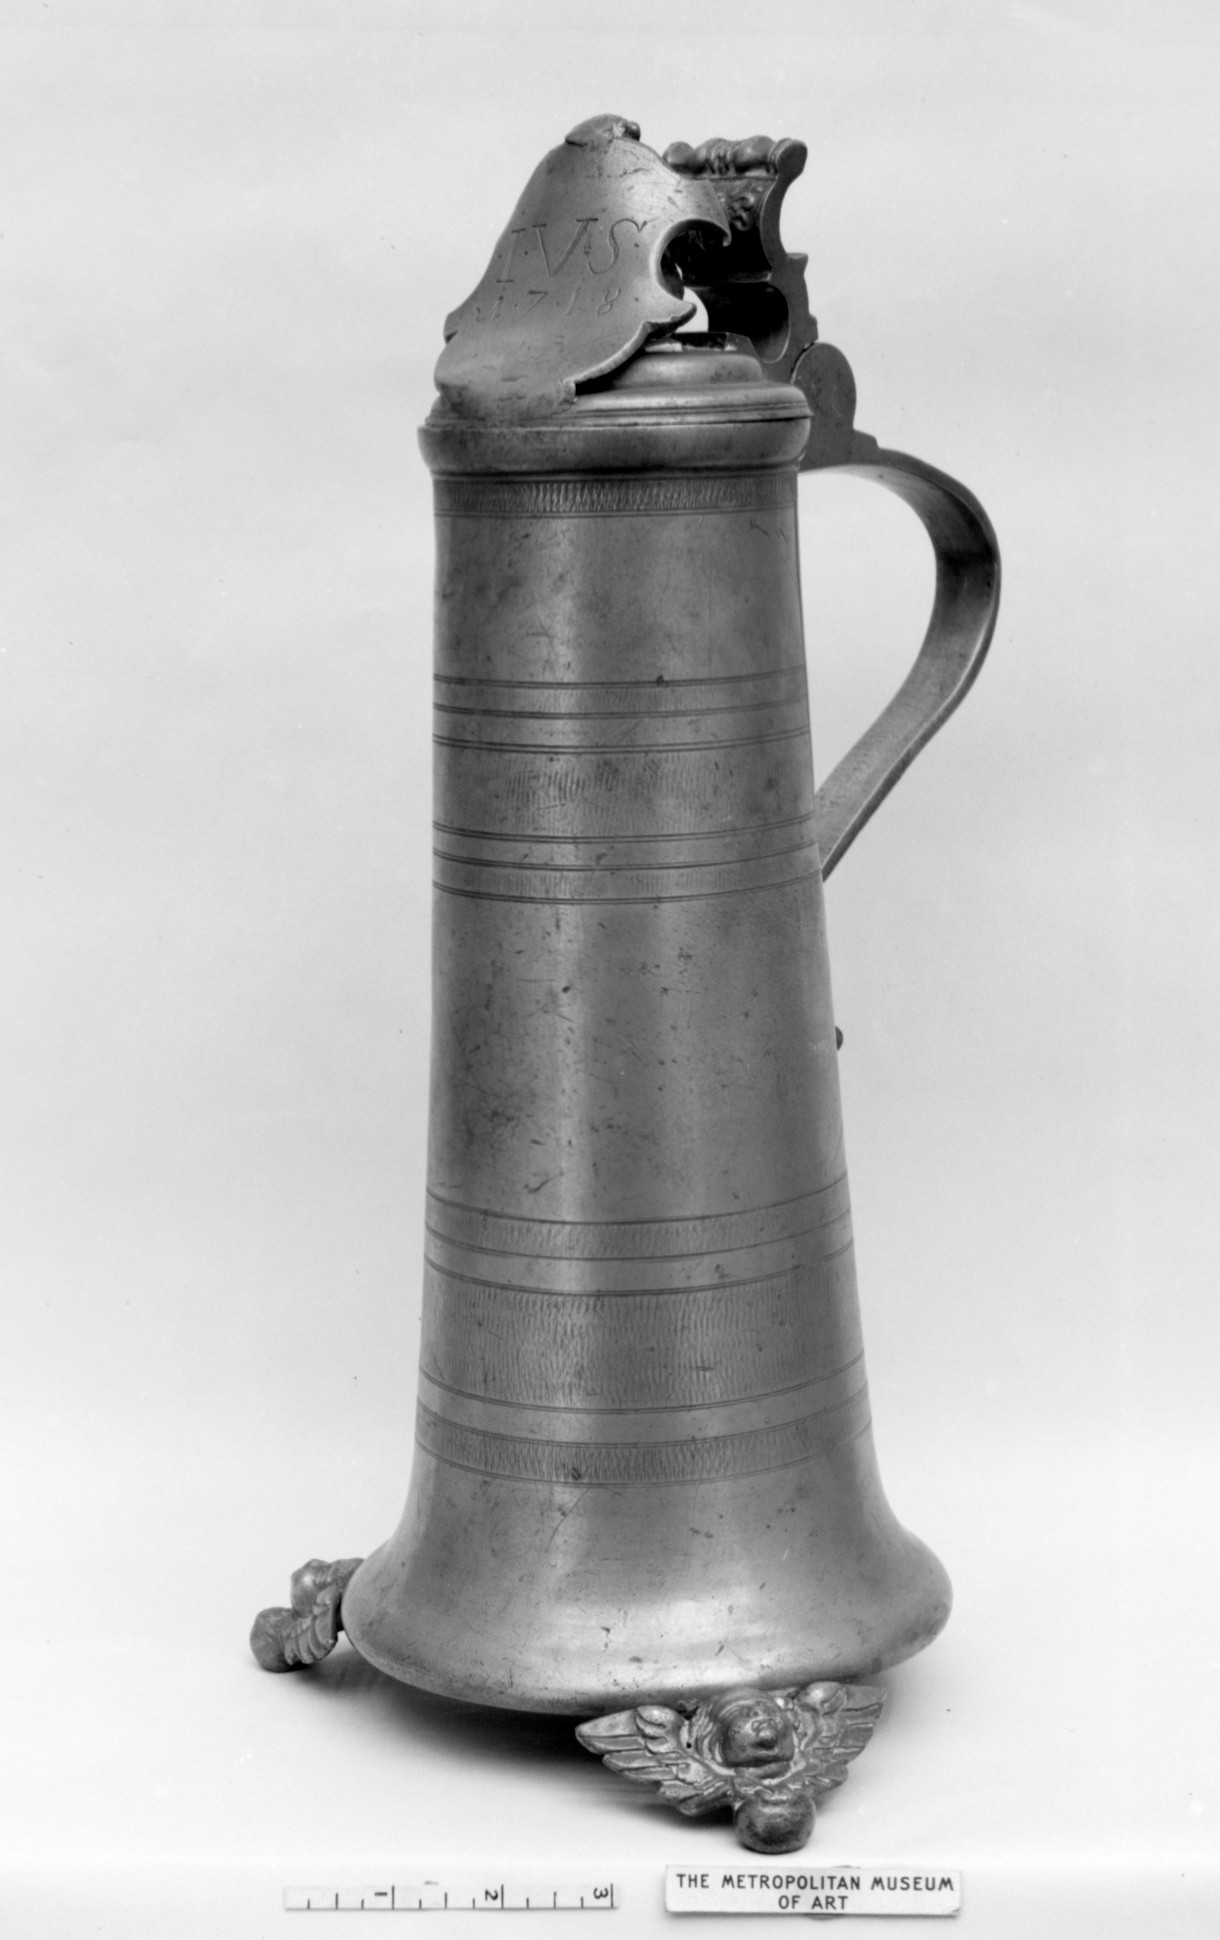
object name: guild tankard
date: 1601-1700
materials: pewter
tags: shields